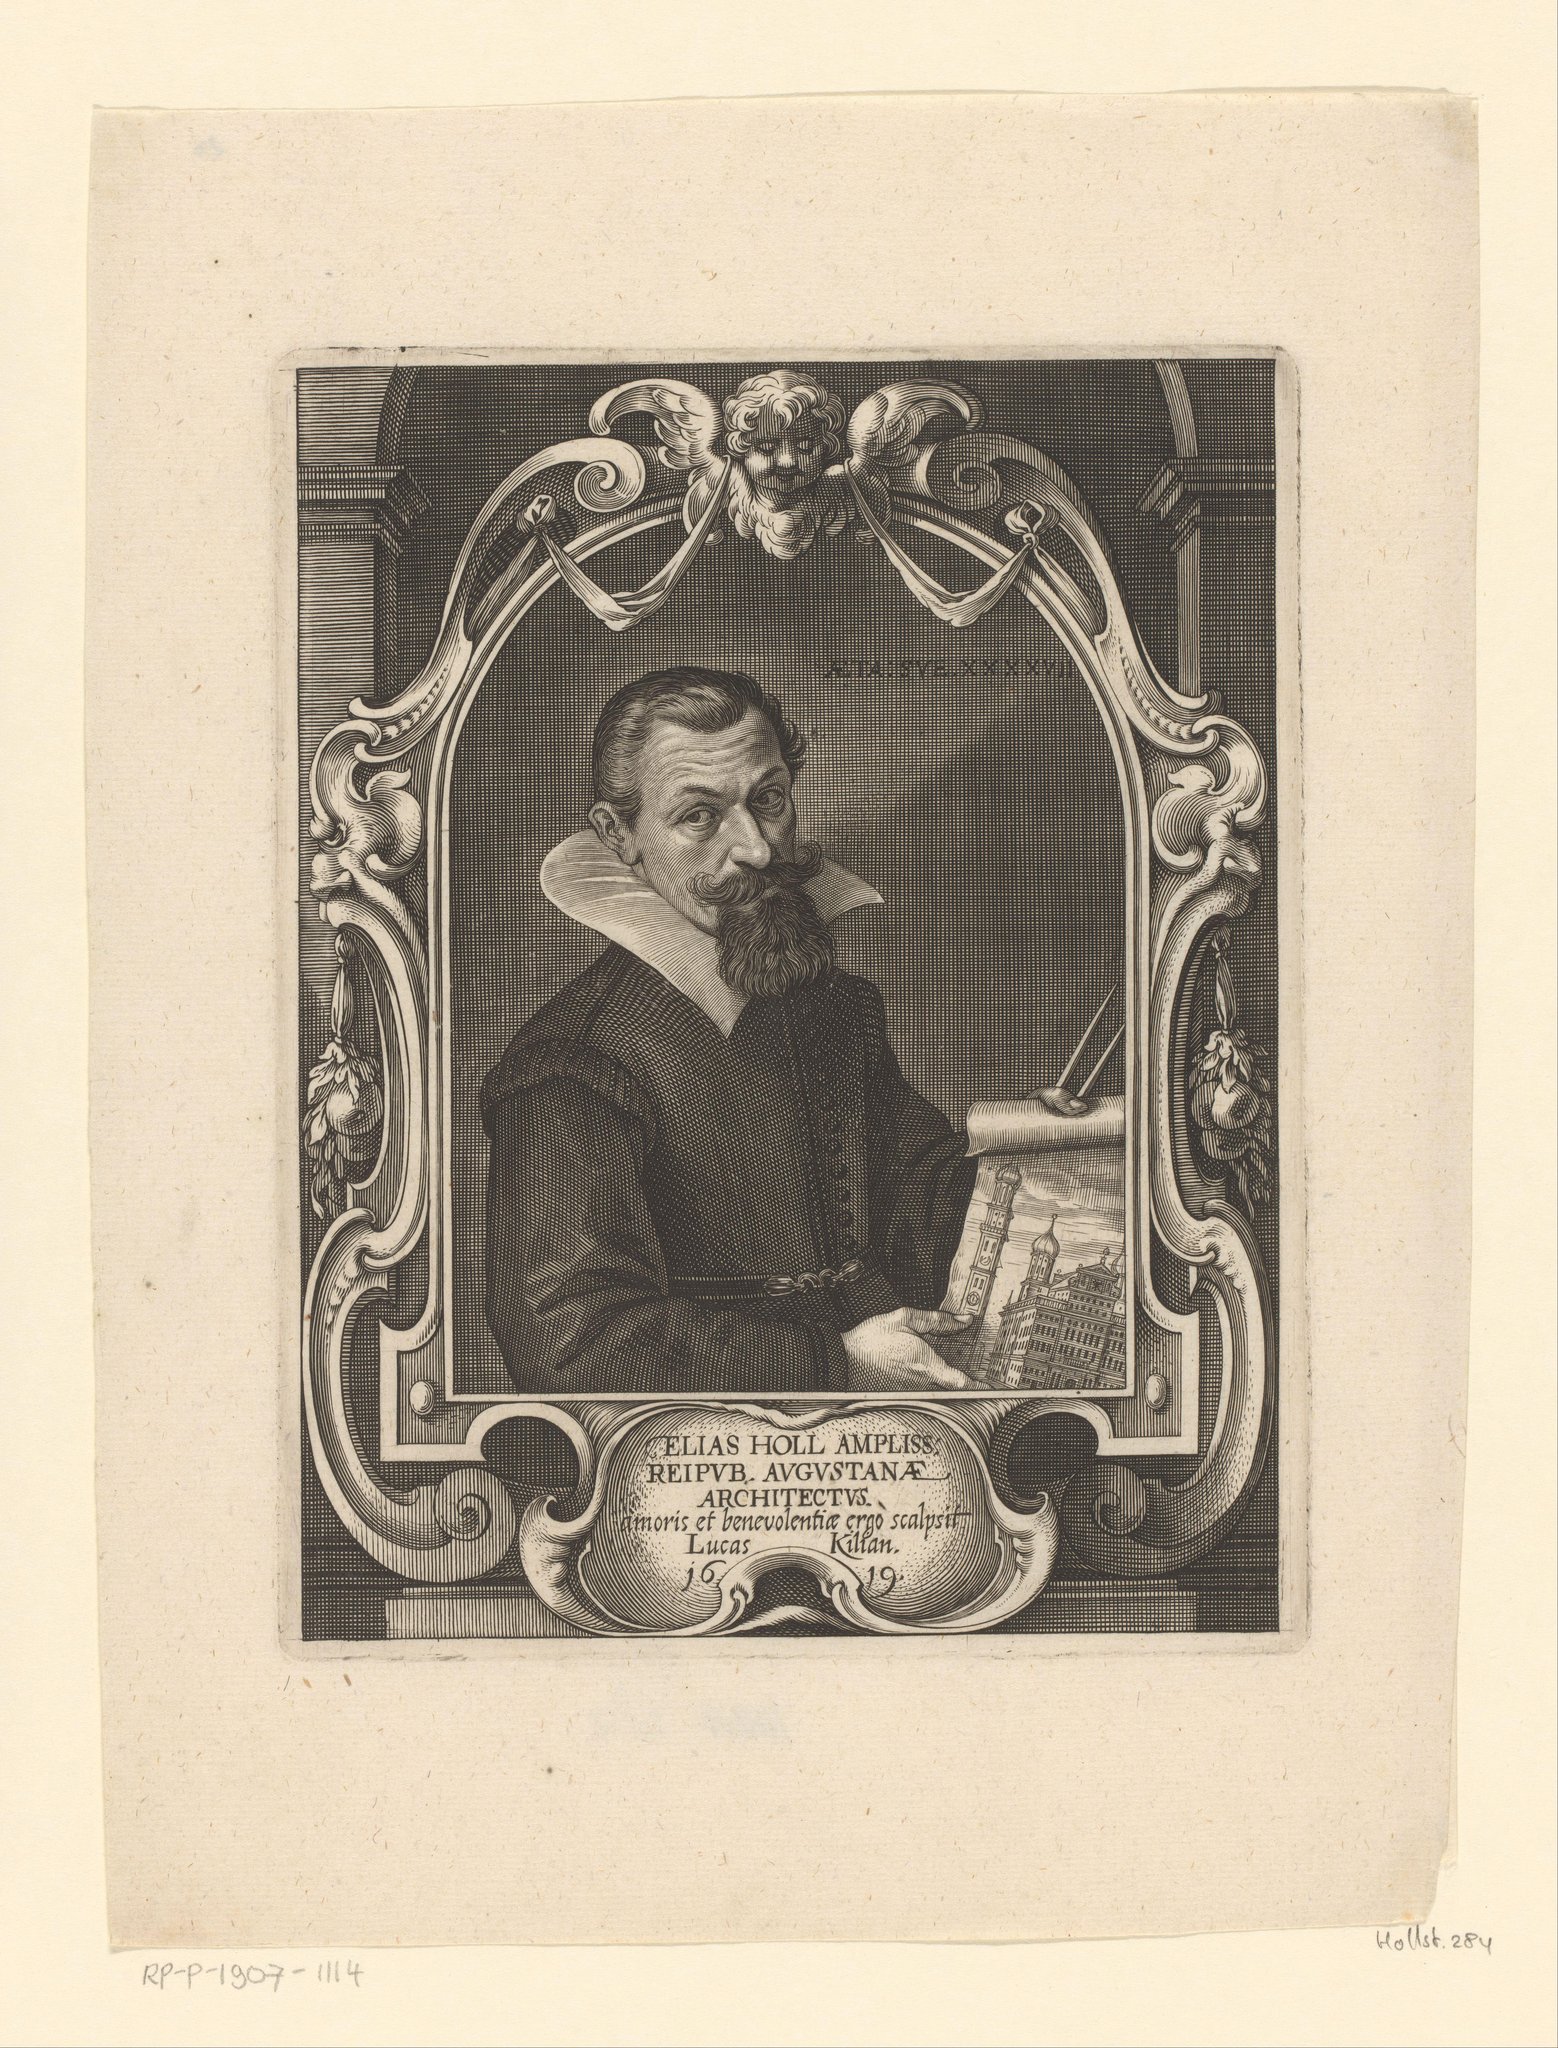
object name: print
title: Portret van Elias Holl op 47-jarige leeftijd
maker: lucas kilian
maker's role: draughtsman, print maker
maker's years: 1579-1637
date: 1619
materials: paper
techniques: engraving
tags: augsburg, elias holl, historical persons, portrait, self-portrait of architect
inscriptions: collector's mark: Lugt 2228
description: In de handen van de geportretteerde een tekening van het stadhuis en de Sint-Petruskerk aan de Perlach te Augsburg. Tekst in het Latijn in de cartouche.